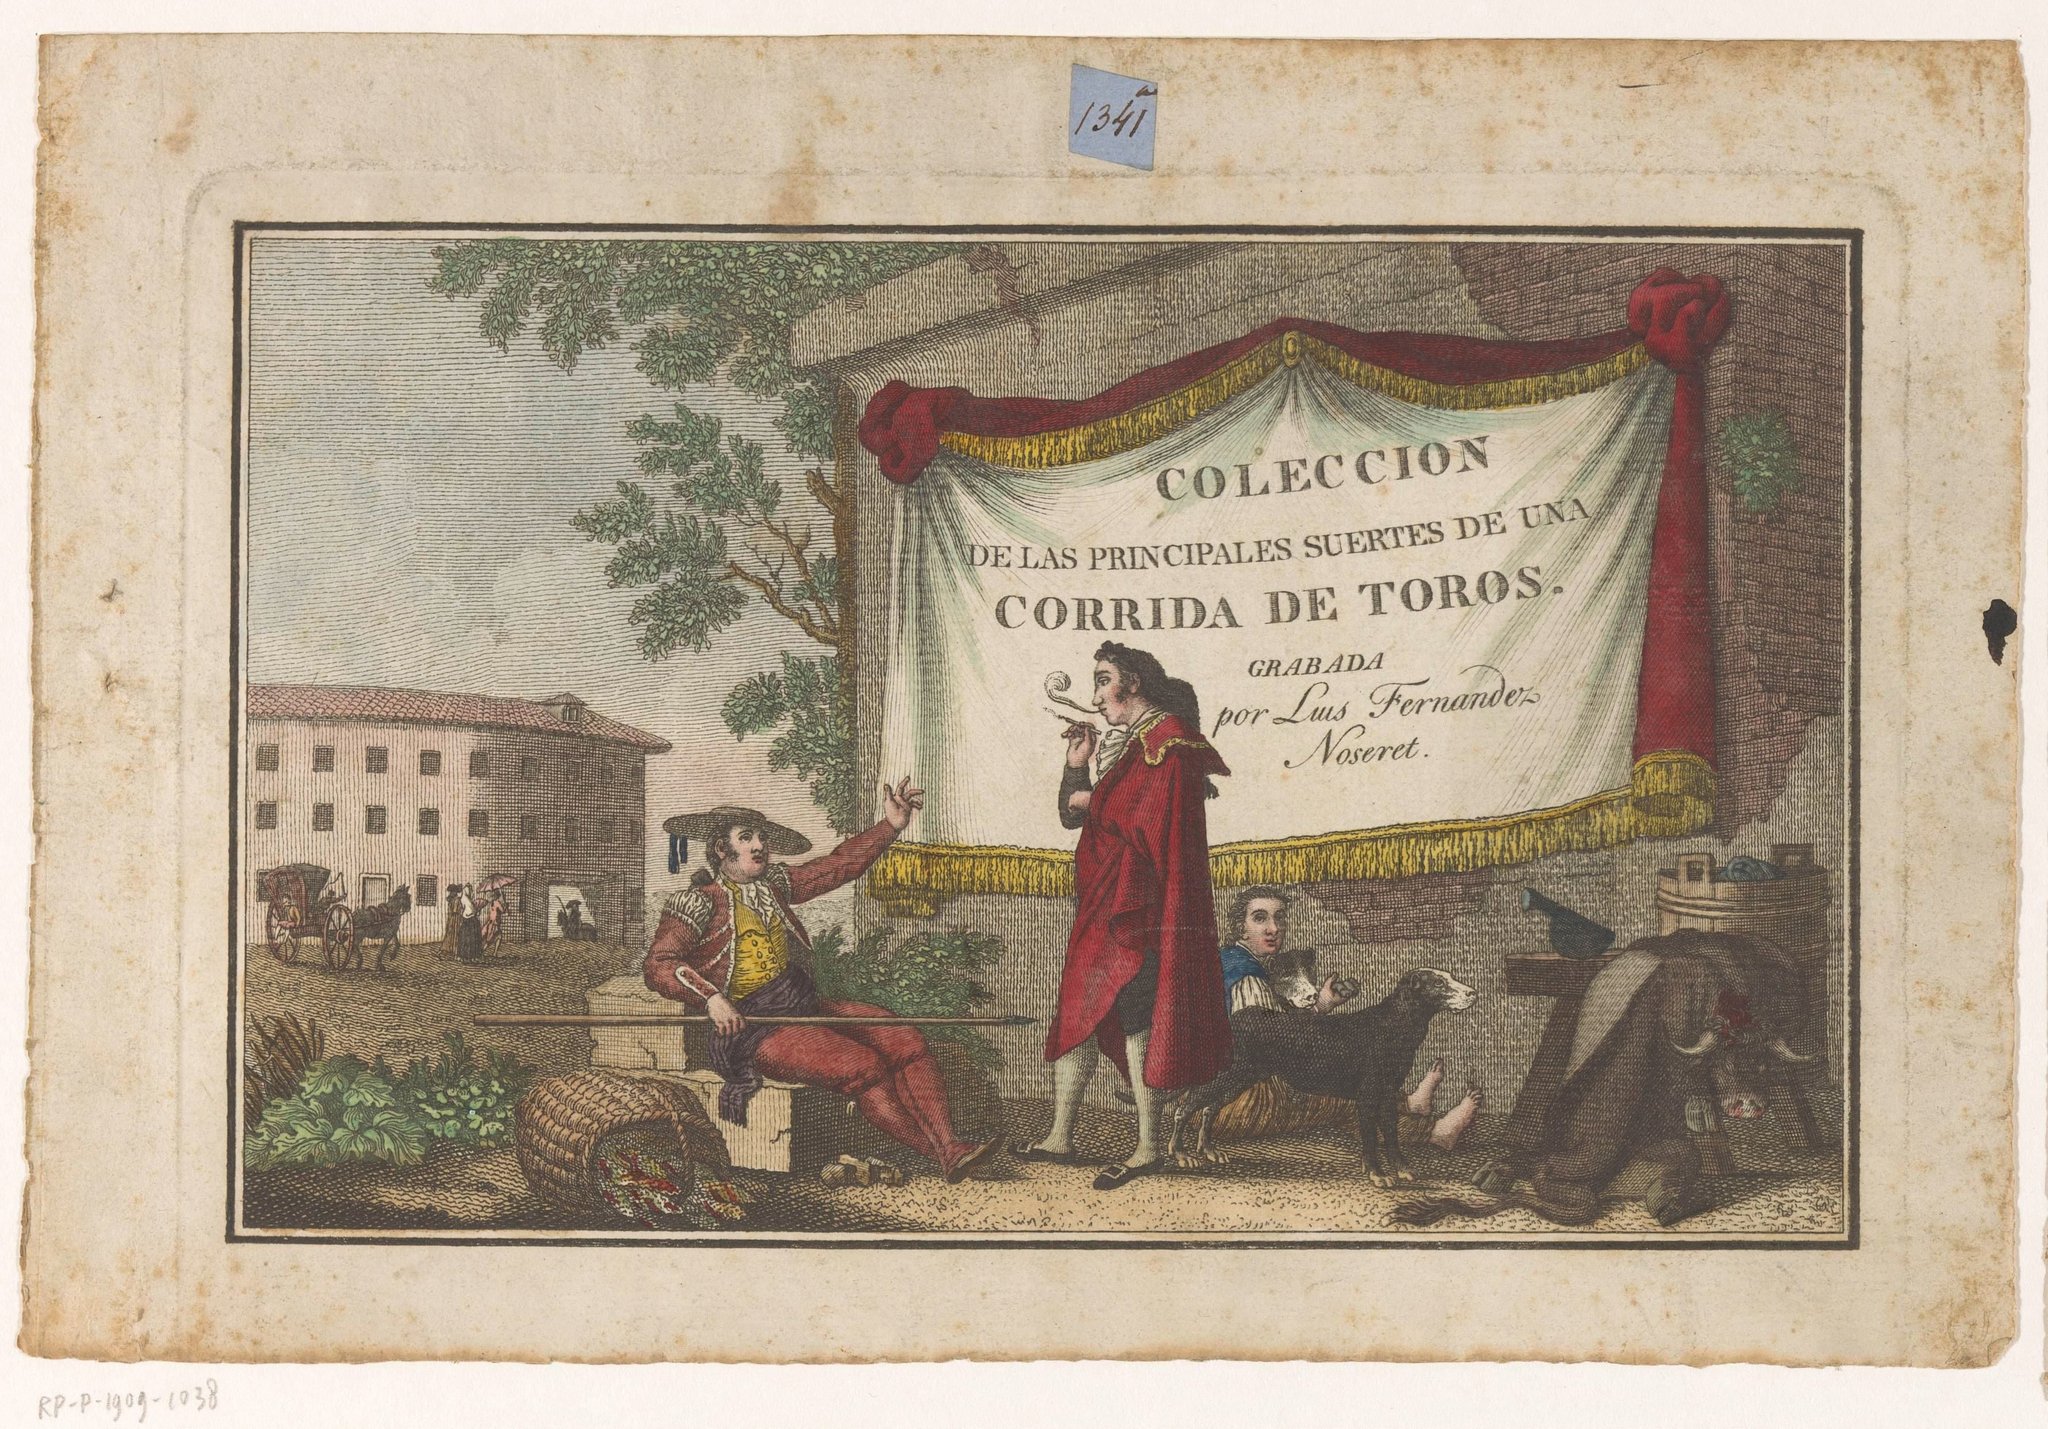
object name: print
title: Verzameling van de belangrijkste manoeuvres bij het stierenvechten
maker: luis fernández noseret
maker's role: print maker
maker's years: 1793-1828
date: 1795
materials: paper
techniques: etching, hand coloring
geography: spain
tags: bull, bullfight, dog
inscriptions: inscription: ‘1341/ a’, collector's mark: Lugt 2228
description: Titelprent met drie stierenvechters (torero's). Een picador zit met een lans in de hand. Naast hem ligt een mand vol banderillas. Een stierenvechter met rode cape staat te roken. Een derde zit op de grond met twee honden.